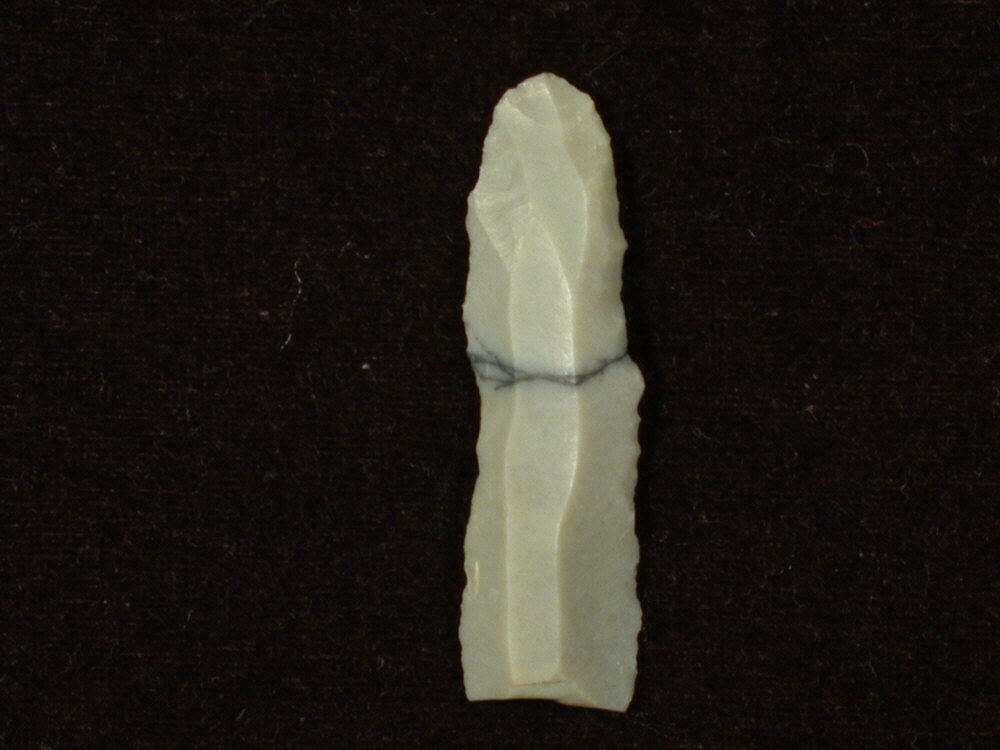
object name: knife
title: Blade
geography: iran